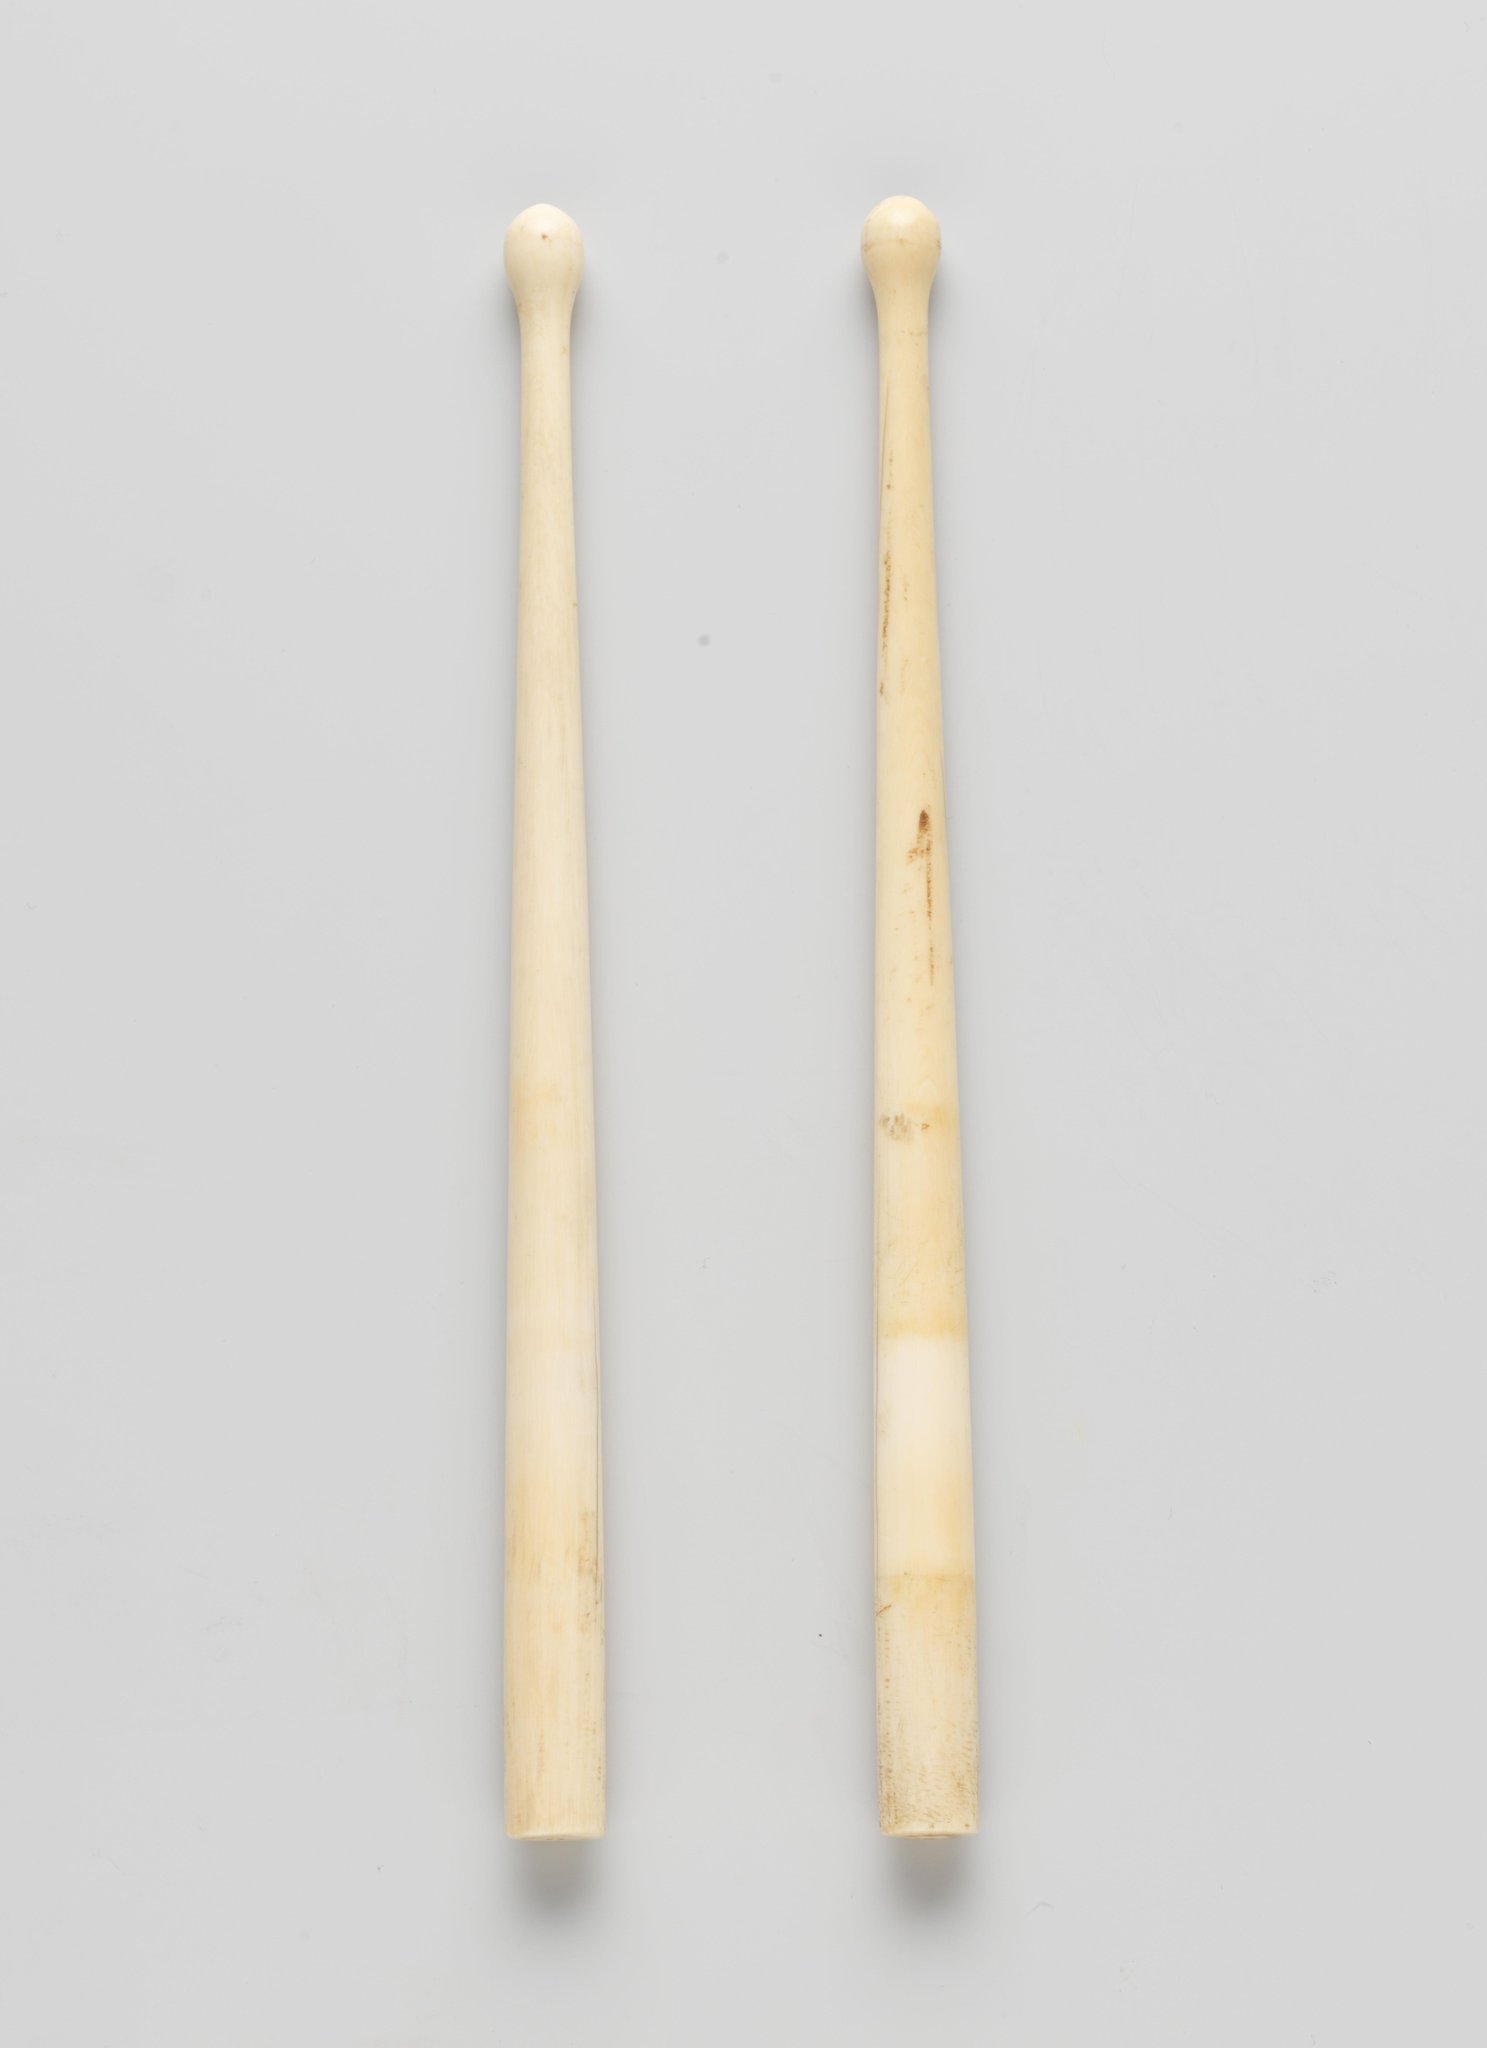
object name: element of musical instrument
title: Drumsticks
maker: Anonymous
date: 1800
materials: ivory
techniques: cutting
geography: europe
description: Stel ivoren trommelstokken. Ivoor met enkele haarscheuren, maar verder in uitstekende conditie.